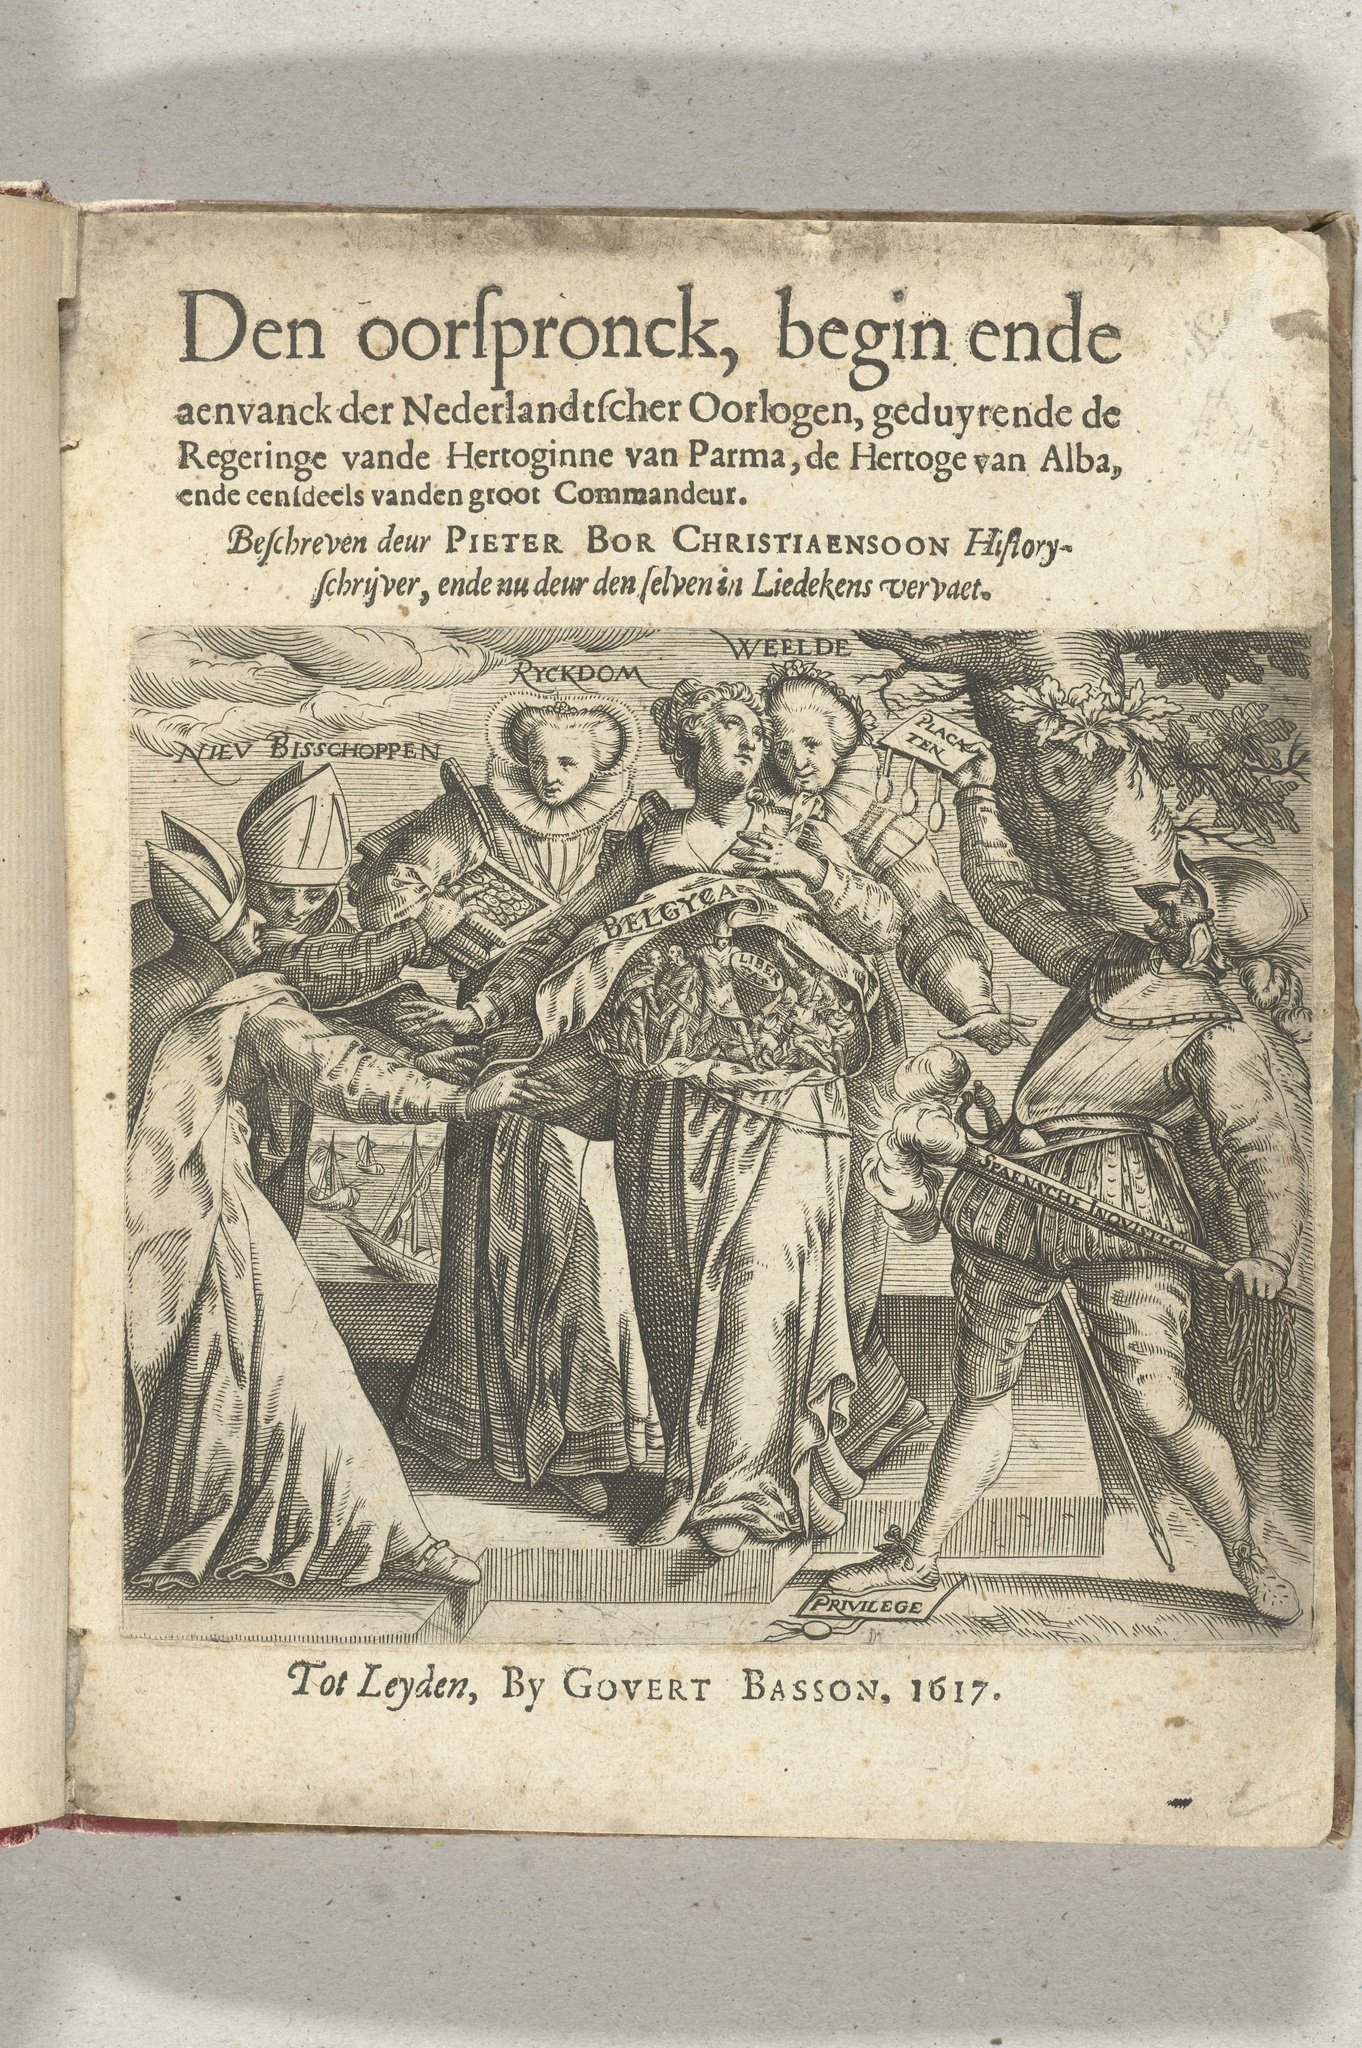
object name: titelblad, titelpagina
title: Allegorische titelpagina in: Pieter Christiaansz Bor, Den oorspronck, begin ende aenvanck der Nederlandtscher oorlogen, 1617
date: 1615-1617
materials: paper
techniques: engraving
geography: northern netherlands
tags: personifications of countries, nations, states, districts, etc., wealth, opulence; 'opulenza', 'richezza' (ripa), inquisition, netherlands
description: Allegorische titelpagina in: Pieter Christiaansz Bor, Den oorspronck, begin ende aenvanck der Nederlandtscher oorlogen, 1617. Nederlandse Maagd Belgyca toont haar buik waarin de vrijheidsstrijd woedt. Om haar heen staan de Nieuwe Bisschoppen, Rijkdom, Weelde en een Spaanse soldaat gewapend met de brandende toorts van de Spaanse Inquisitie.